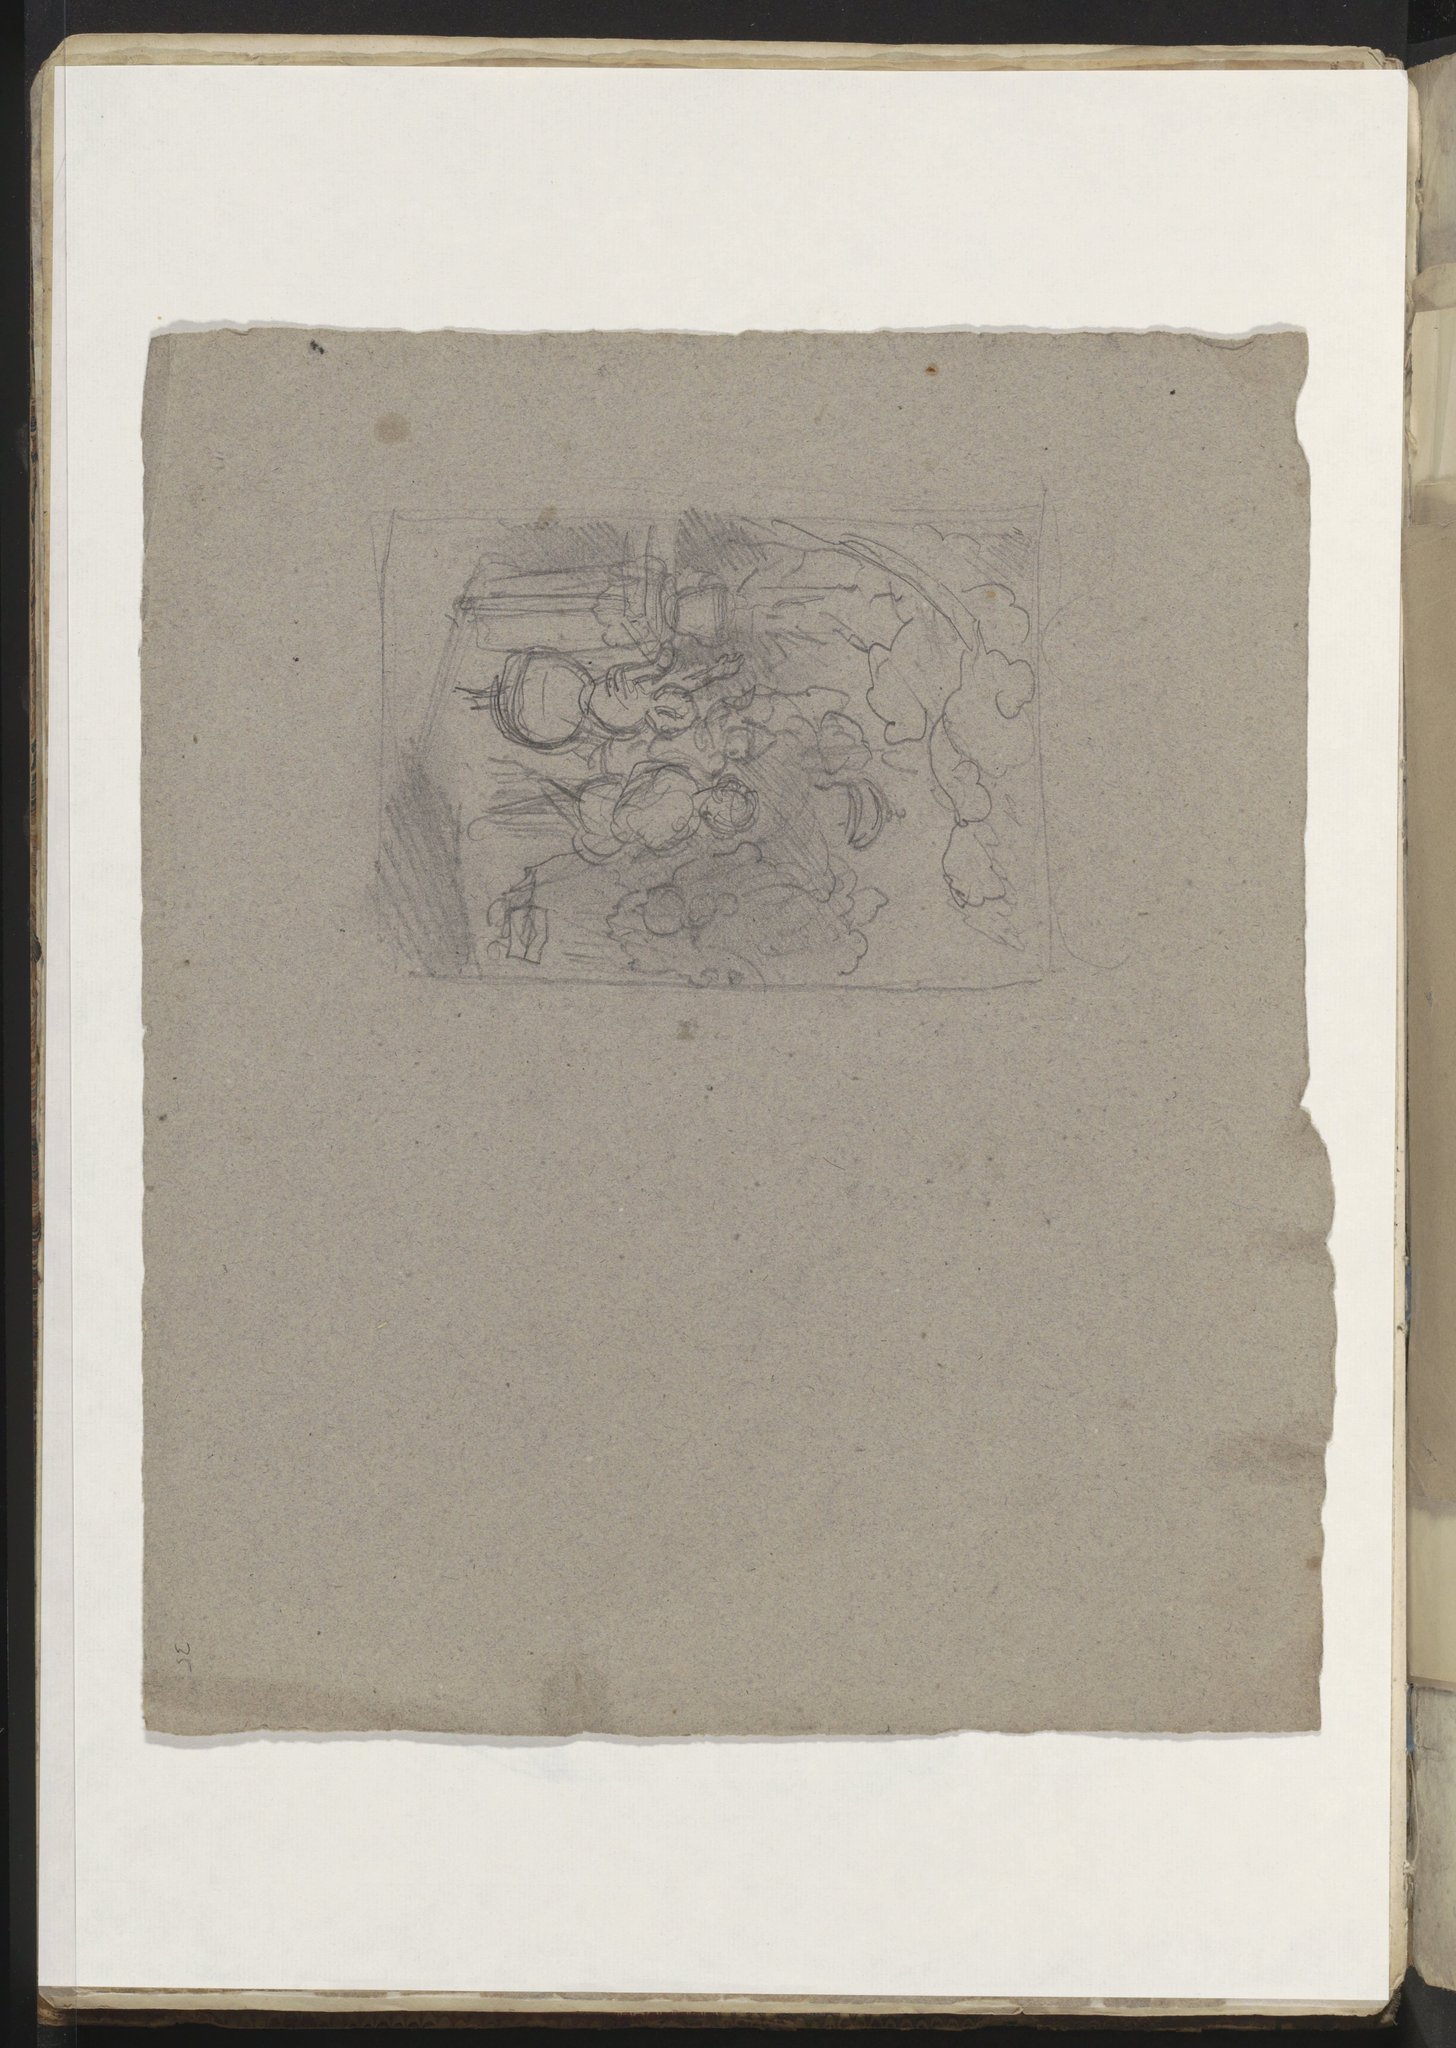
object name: sketchbook leaf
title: Groep kinderen bij een kruik op een sokkel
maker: johannes huybertus van hove bzn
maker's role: print maker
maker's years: 1827-1881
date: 1837-1881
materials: paper, pencil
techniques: stumping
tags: child, container of ceramics: jar, jug, pot, vase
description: Blad 35 verso, los blad in een schetsboek met 33 bladen en 10 losse tekeningen.